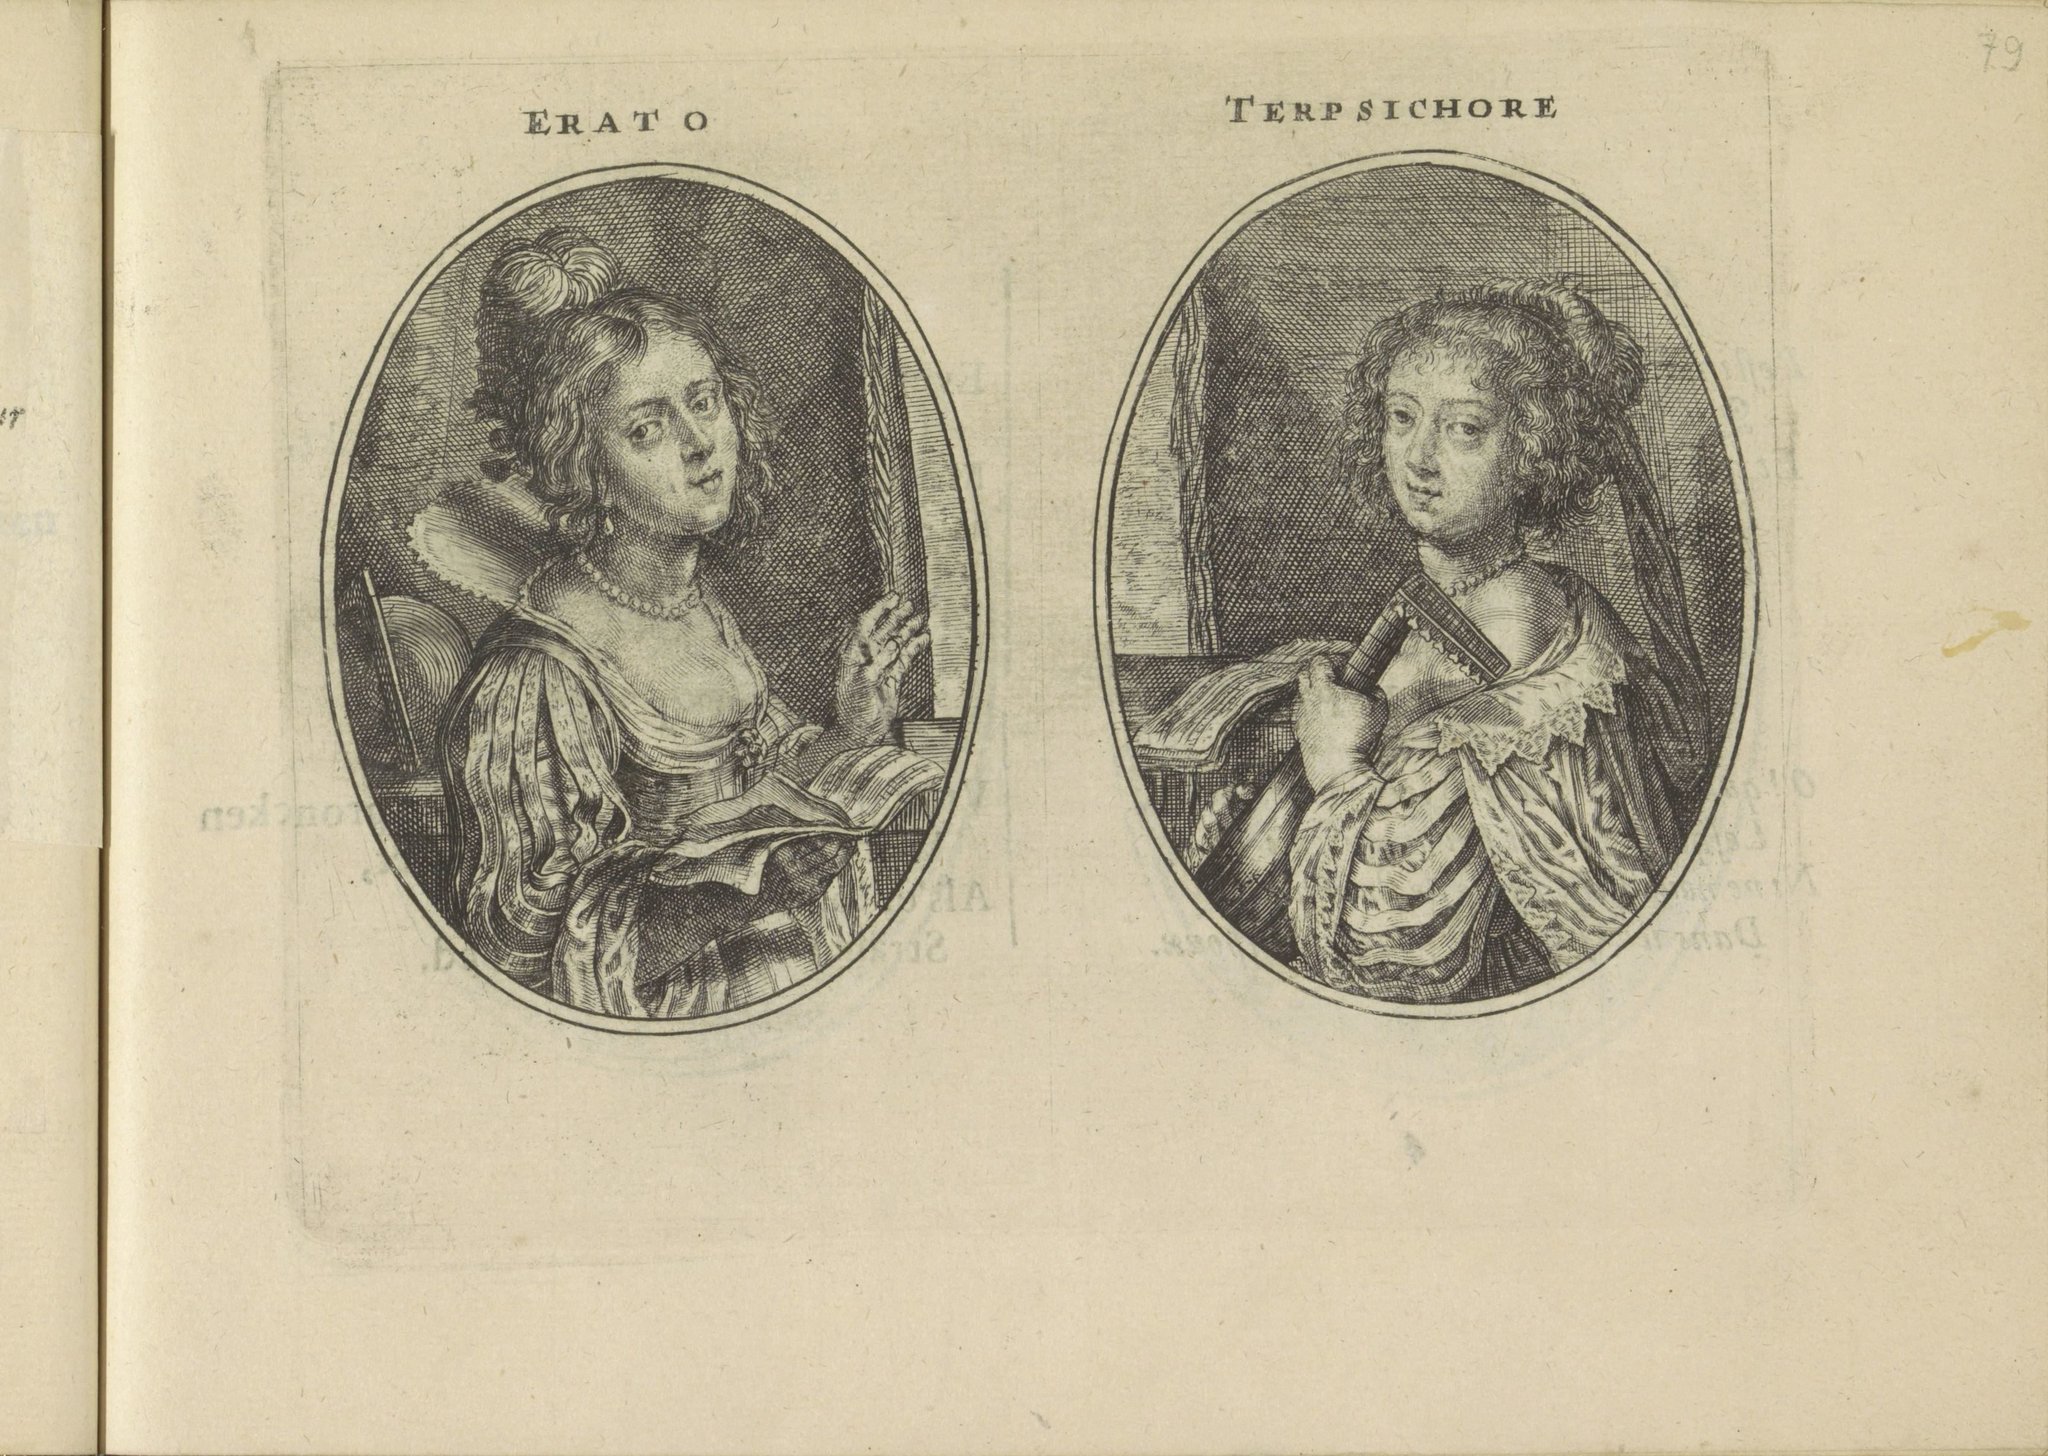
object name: album leaf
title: Erato en Terpsichore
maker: crispijn van de passe (ii)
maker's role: draughtsman, print maker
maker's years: 1594-1670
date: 1640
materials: paper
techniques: engraving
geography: amsterdam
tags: notation of music, lute, and special forms of lute, e.g.: theorbo, erato (one of the muses); 'erato' (ripa), terpsichore (one of the muses); 'terpsicore' (ripa)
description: Twee voorstellingen op een albumblad. Links de muze Erato bij een venster, met een muziekboek in haar handen. Rechts Terpsichore met luit en een muziekboek in het raamkozijn. Het blad maakt deel uit van een album.